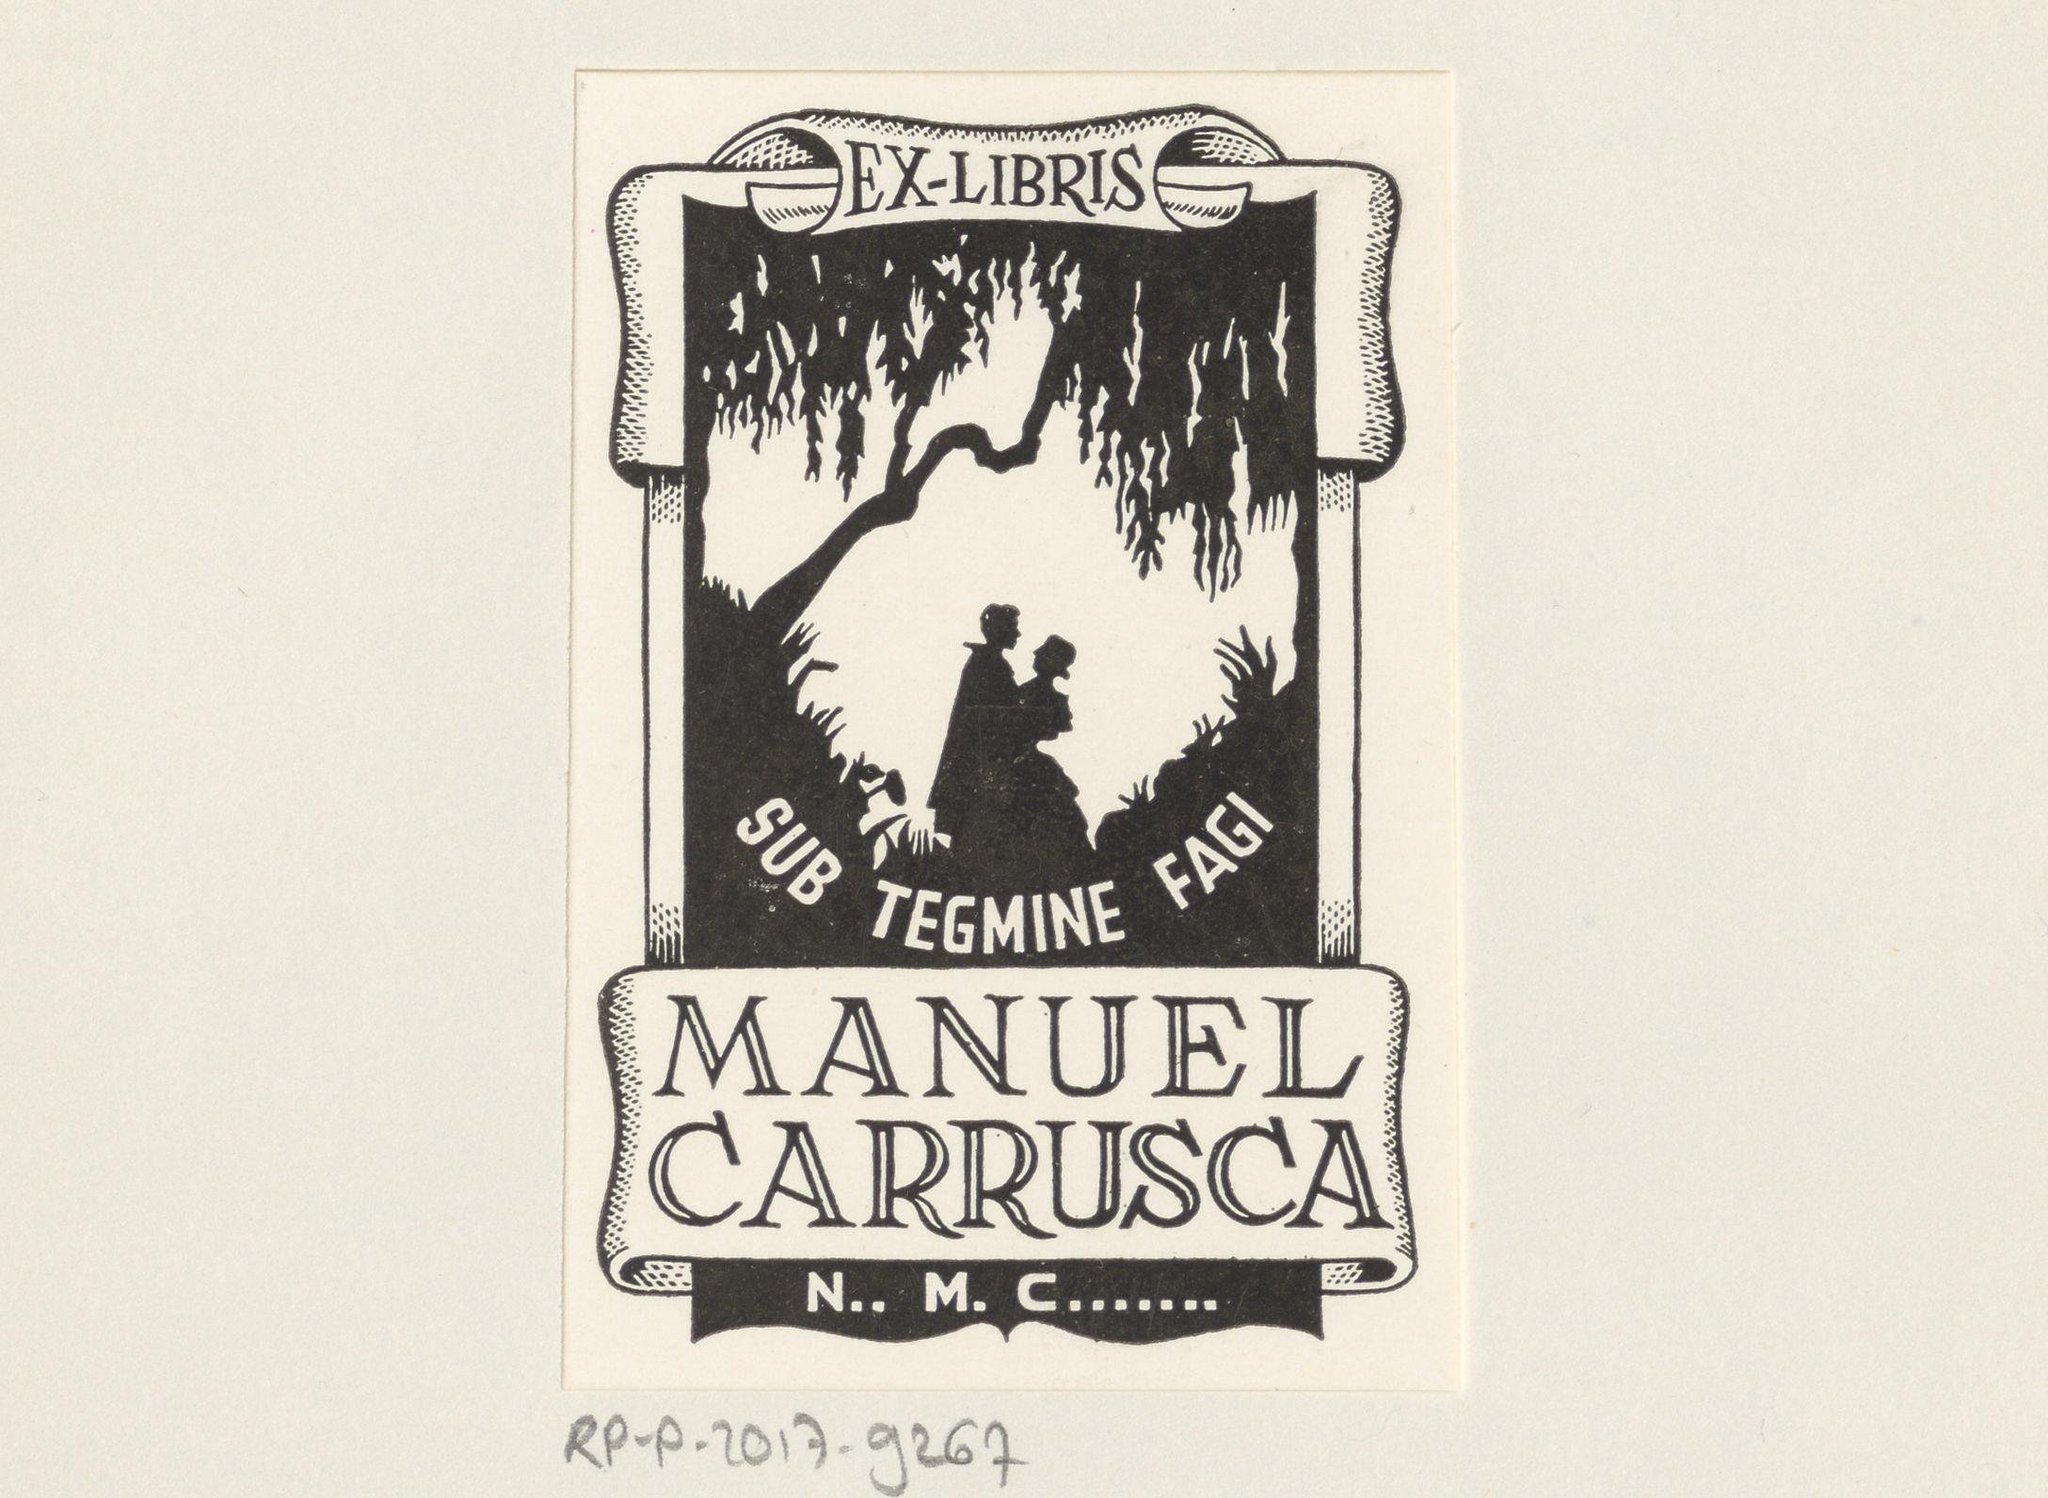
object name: bookplate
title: Ex libris van Manuel Carrusca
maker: Anonymous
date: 1900-1999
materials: paper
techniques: printing block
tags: trees, couple of lovers